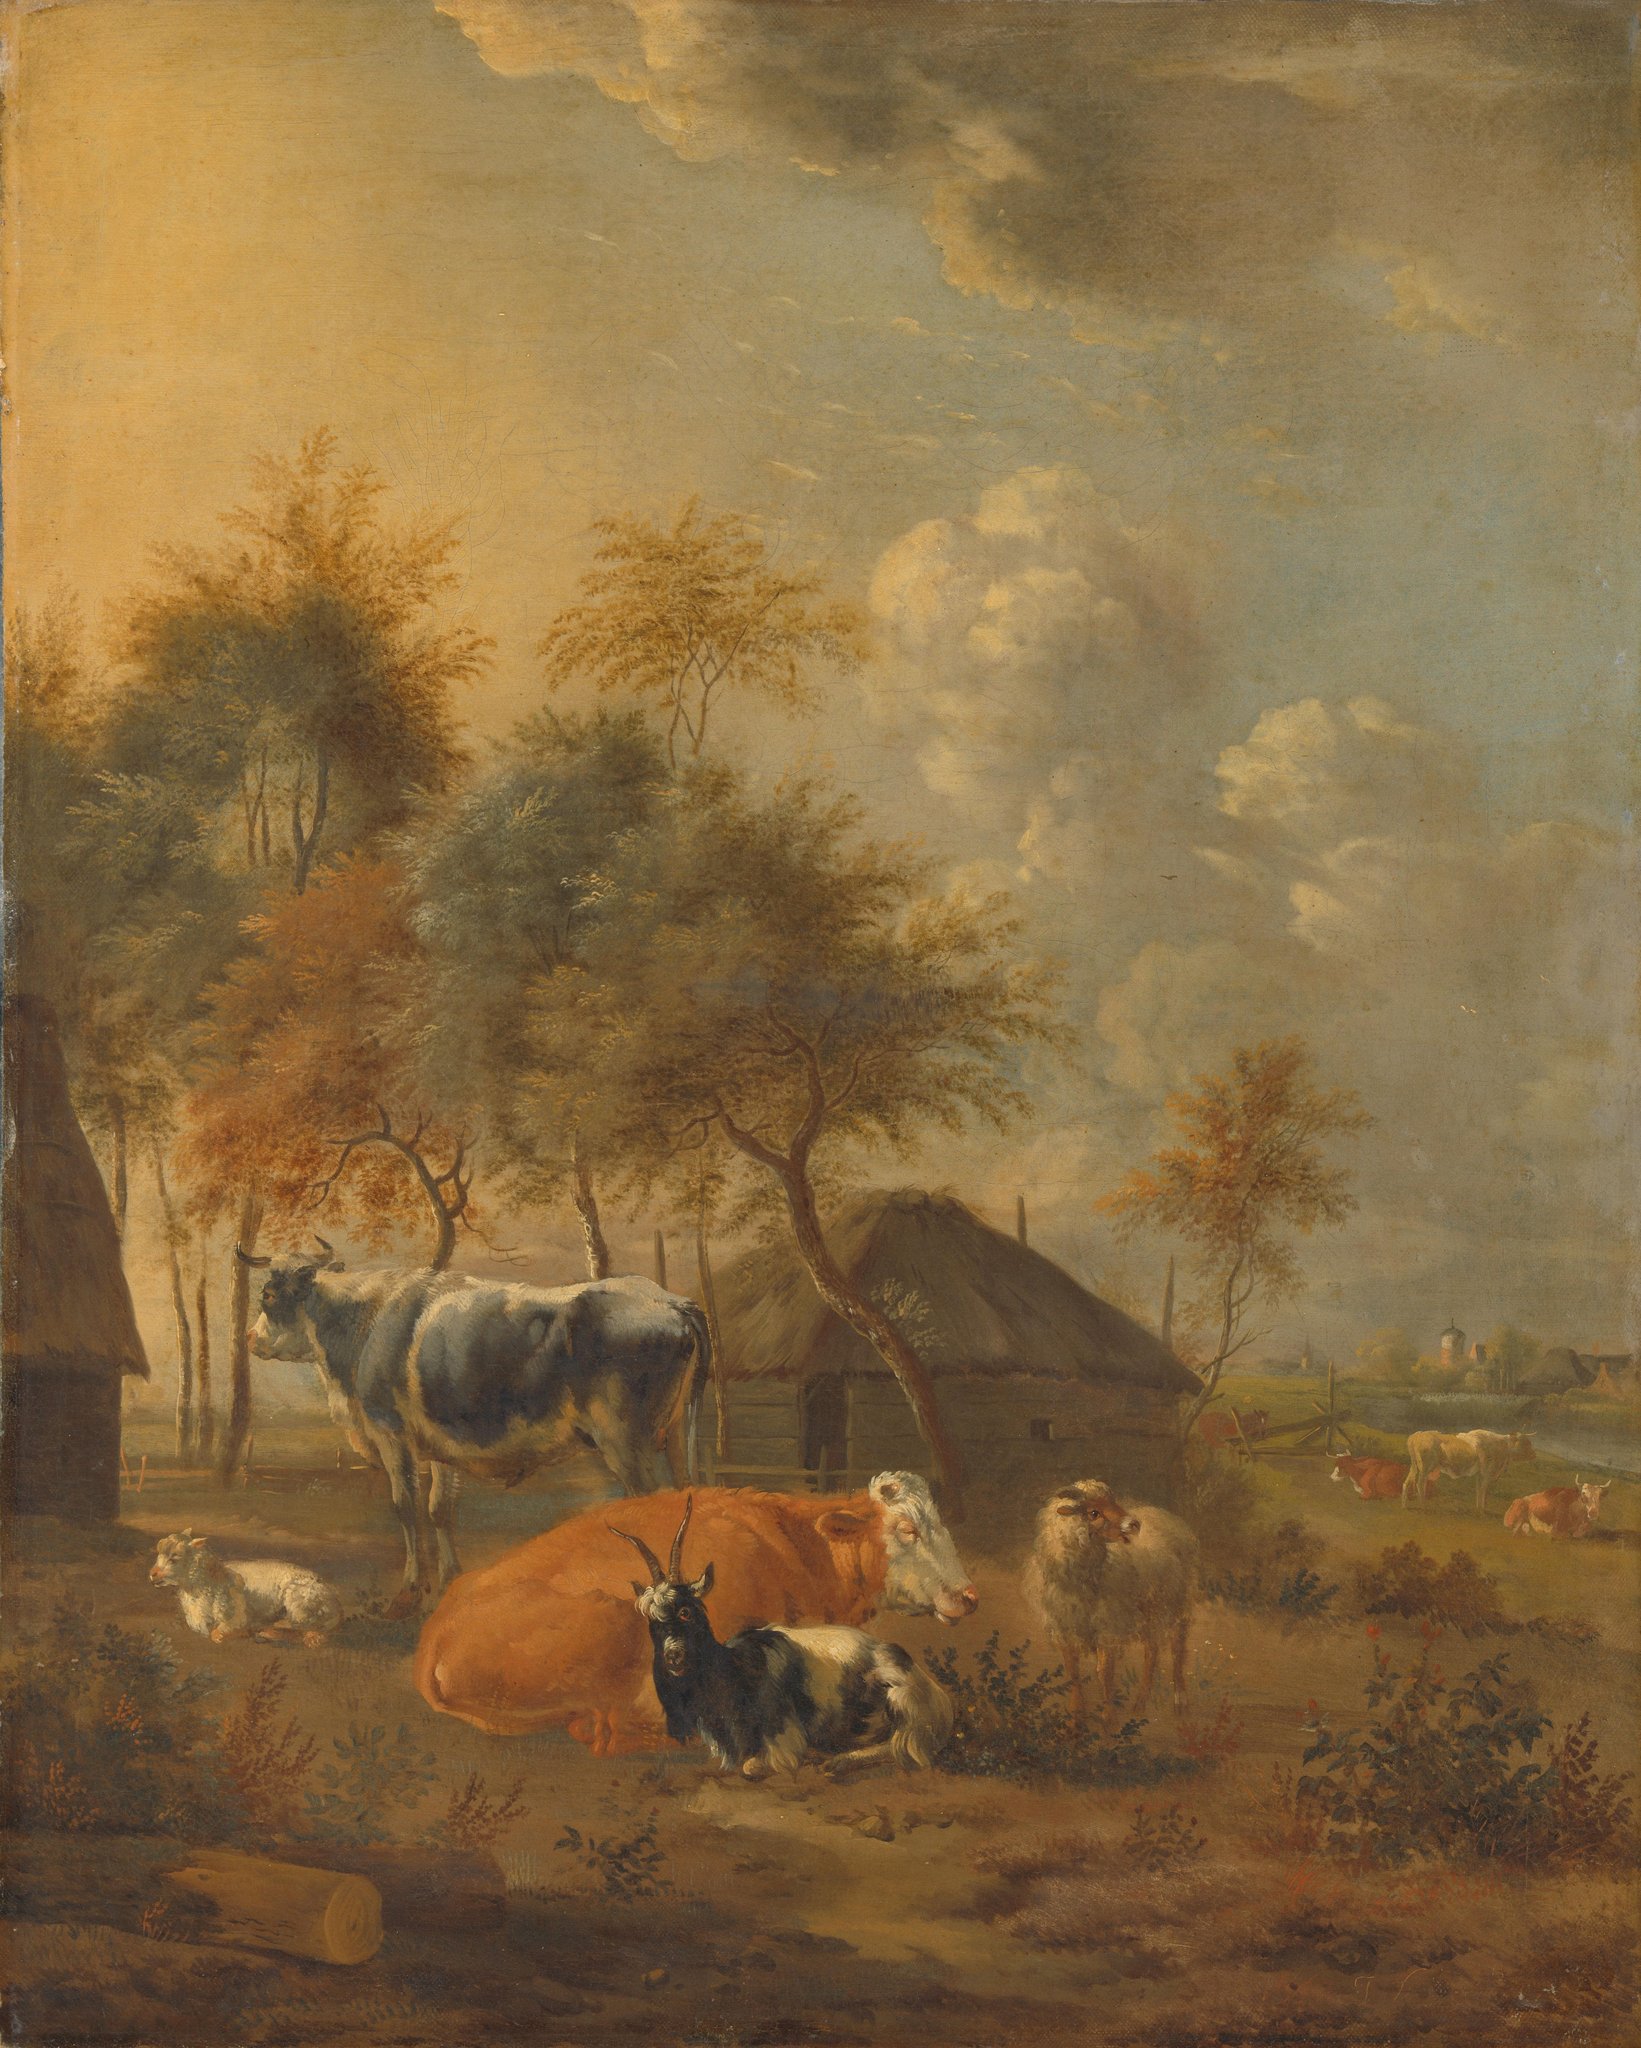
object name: painting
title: Landscape with Animals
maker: monogrammist il (schilder)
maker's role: painter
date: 1700-1799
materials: canvas, oil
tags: cattle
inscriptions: signature: ‘IL’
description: Landschap met vee. Koeien, geiten en schapen op een veldje achter een boerderij, rechts een schuur.